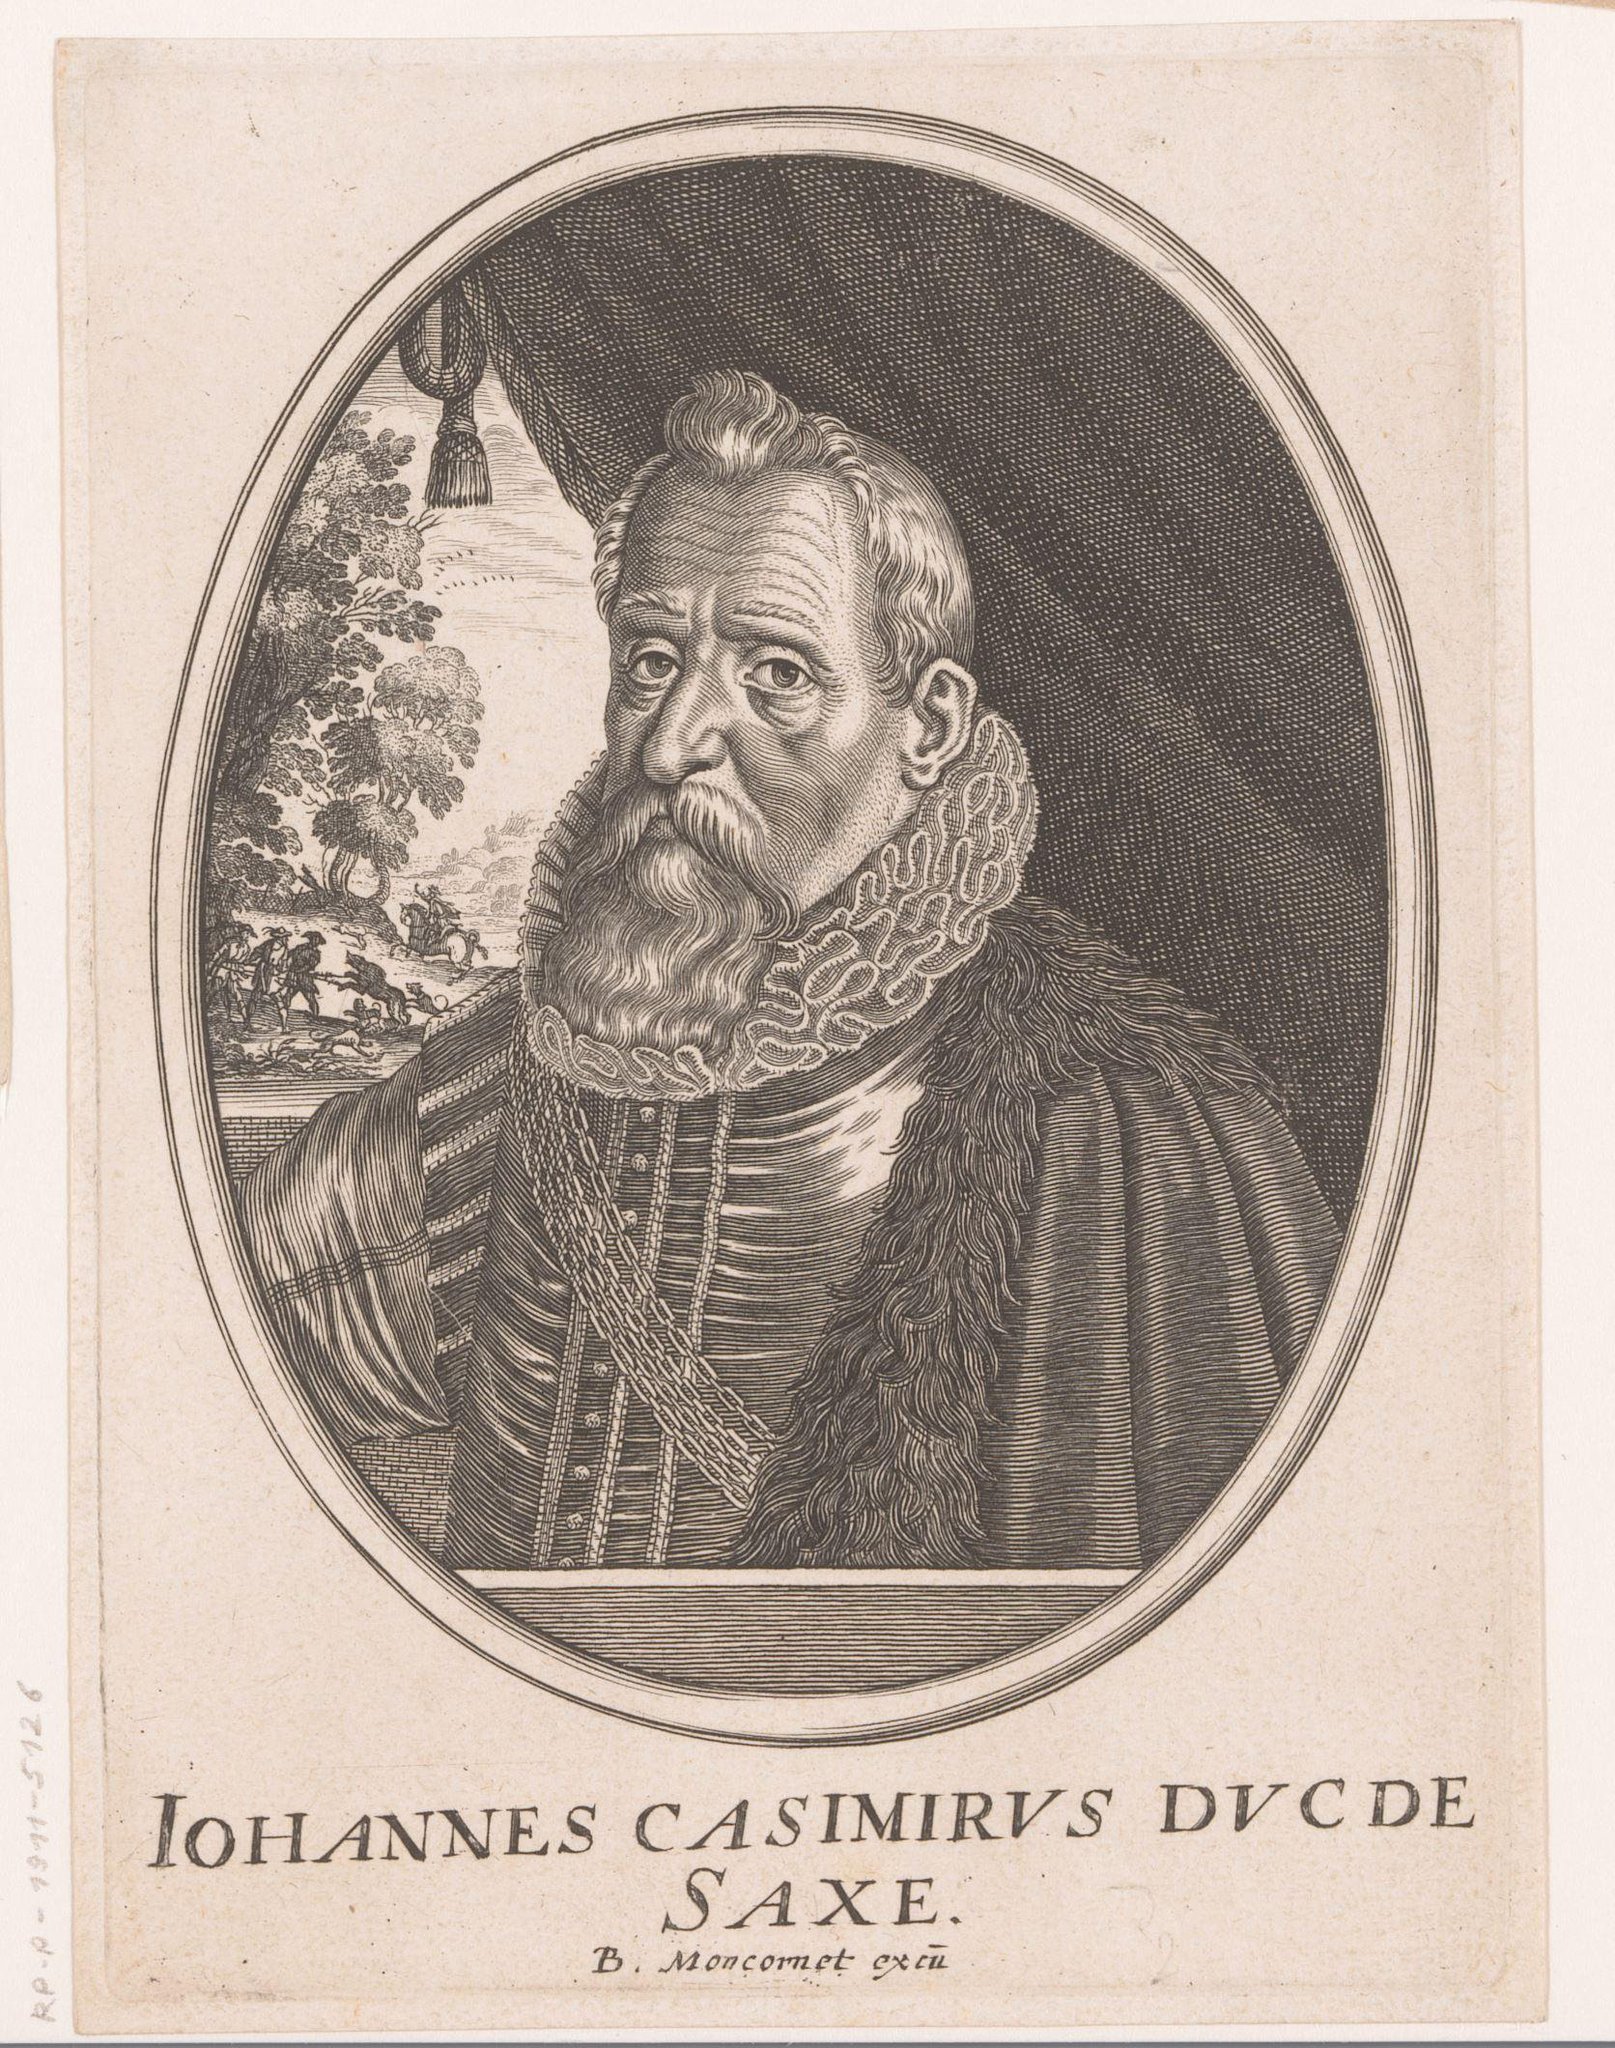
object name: print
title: Portret van Johann Casimir Saksen-Coburg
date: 1610-1668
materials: paper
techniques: engraving, etching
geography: paris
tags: historical persons, nobility and patriciate; chivalry, knighthood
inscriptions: collector's mark: Lugt 2228